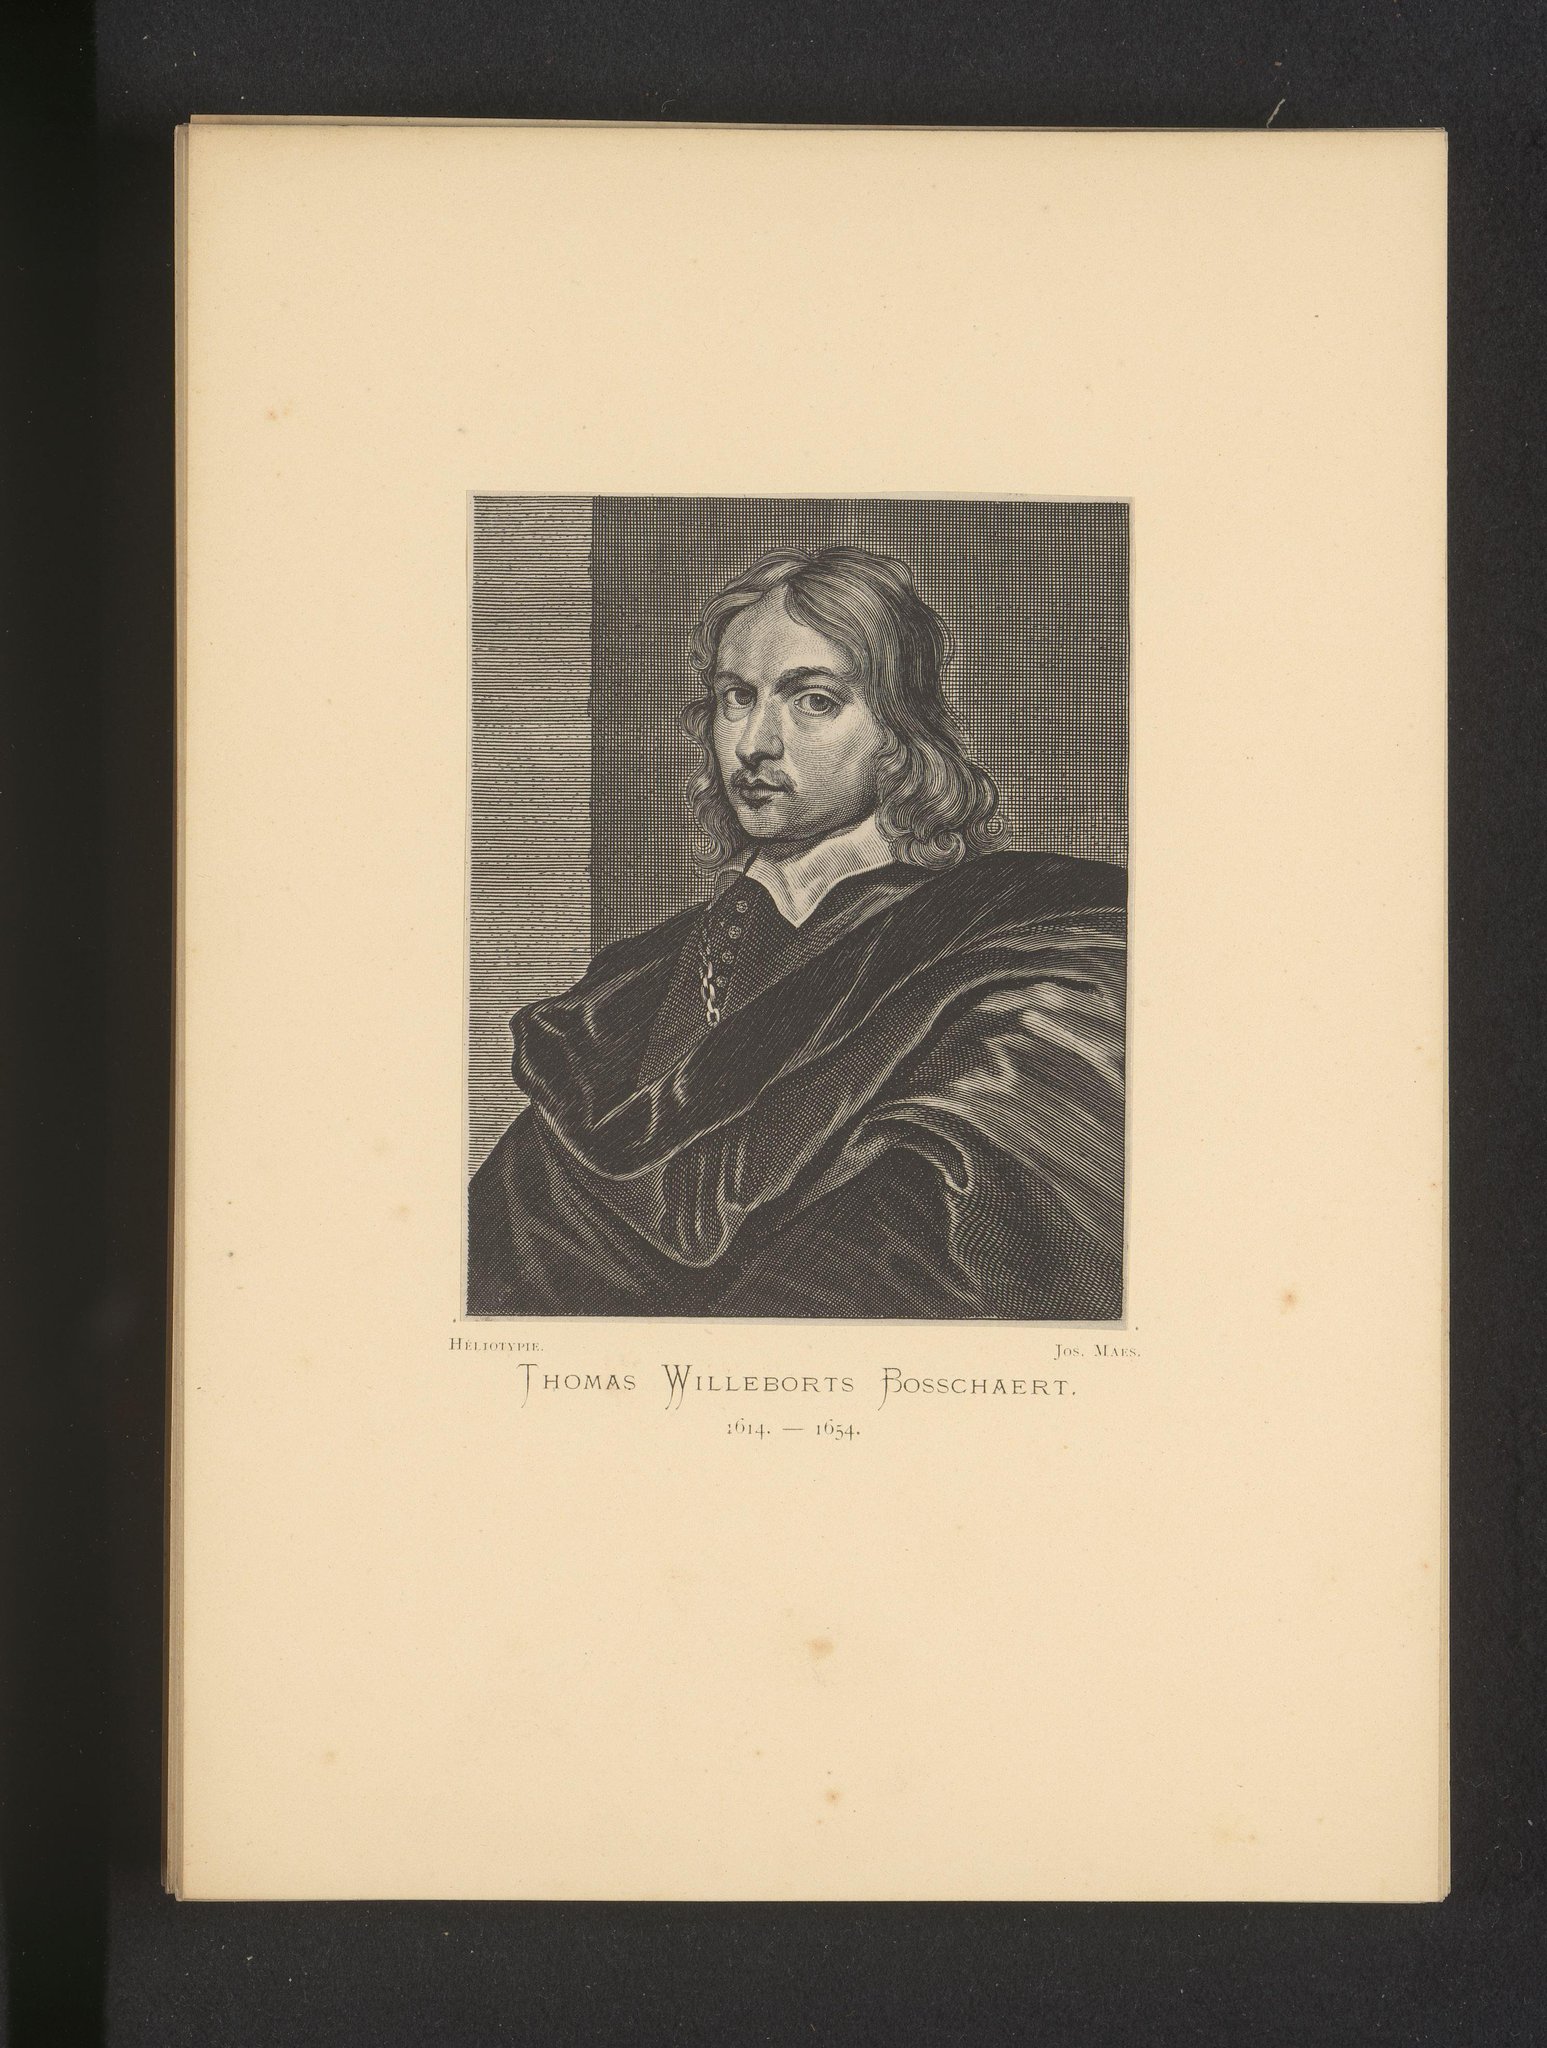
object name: photomechanical print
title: Thomas Willeborts Bosschaert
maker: joseph maes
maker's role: fotograaf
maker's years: 1838-1908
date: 1872-1877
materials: cardboard, paper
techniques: photograph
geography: antwerp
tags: bergen op zoom, antwerp, painter, draughtsman, thomas willeboirts bosschaert, historical persons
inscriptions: inscription: ‘1614. - 1654.’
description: Deze prent maakt deel uit van een omslag met 150 prenten en een katern met een lijst van afbeeldingen.